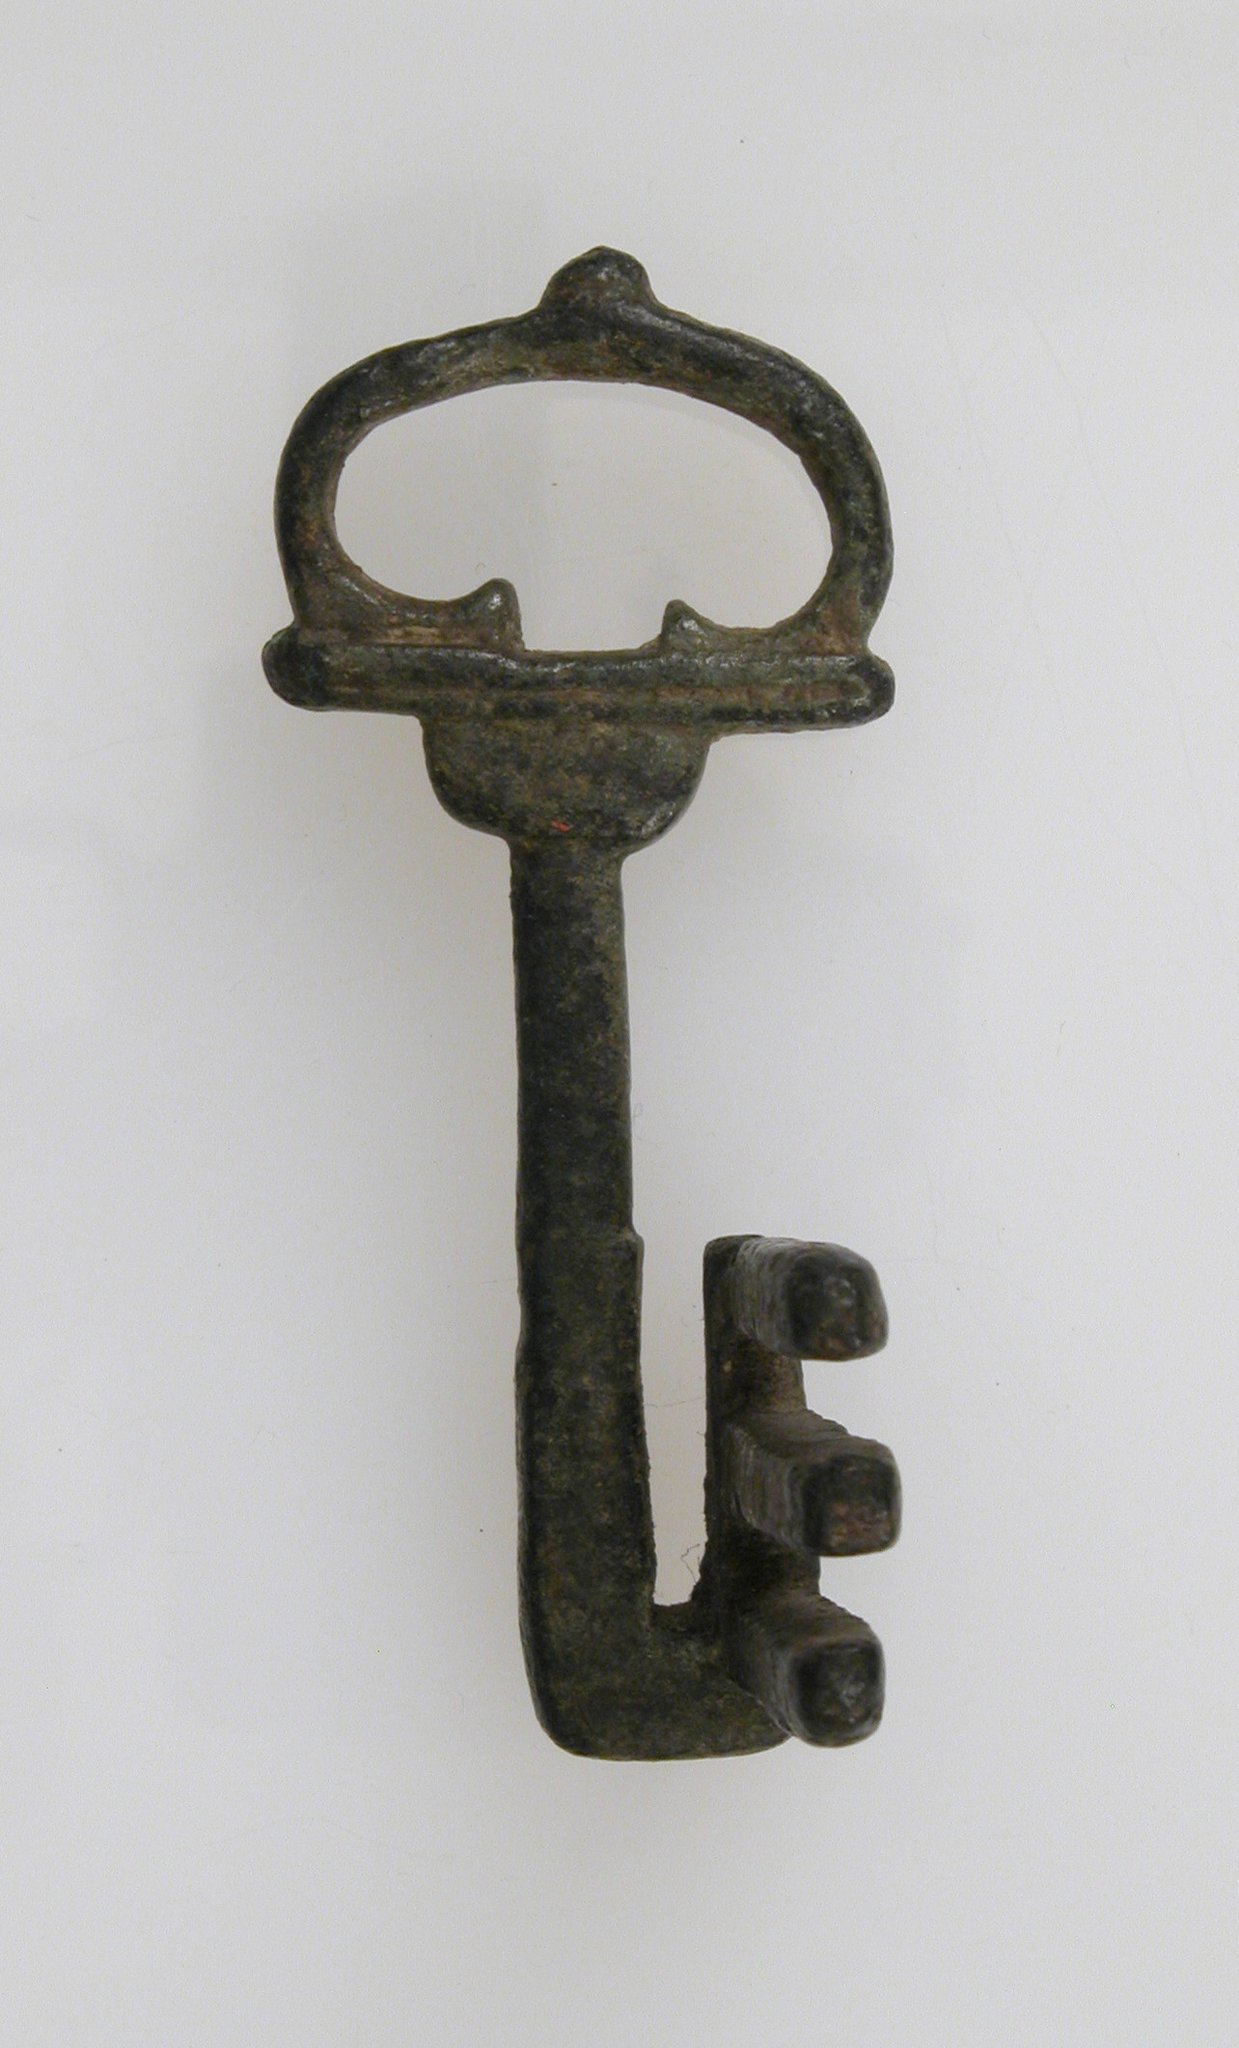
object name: key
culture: roman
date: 1-300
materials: copper alloy